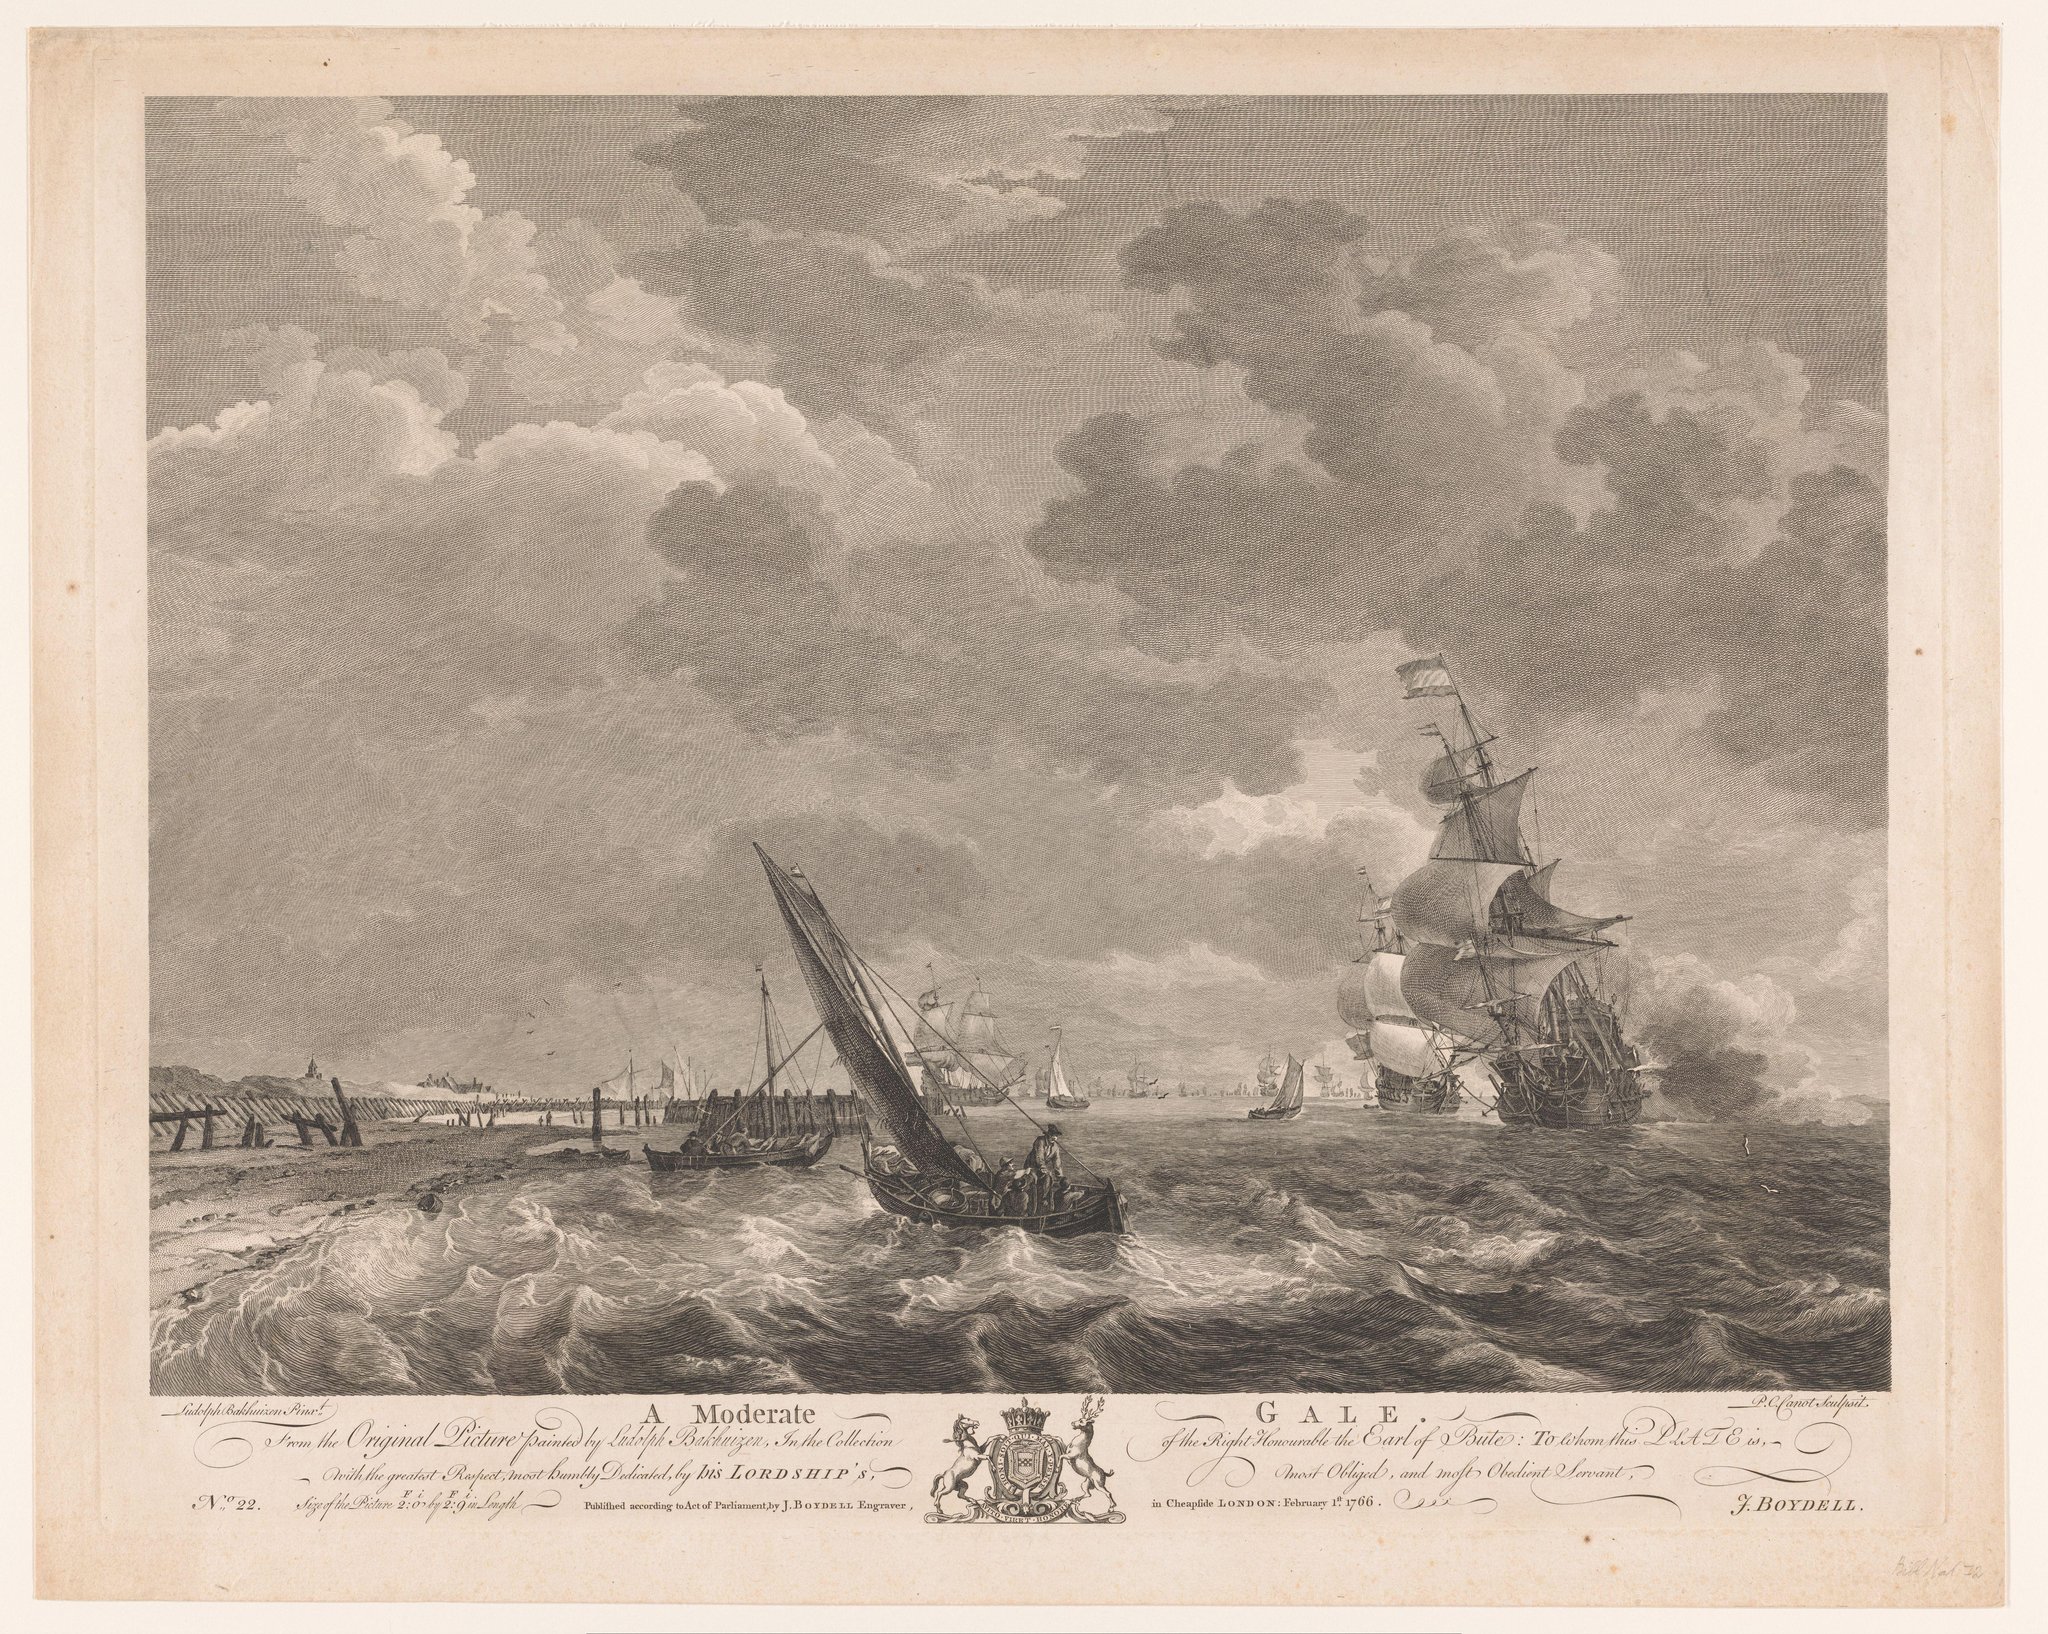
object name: print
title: A Moderate Gale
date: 1766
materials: paper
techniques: engraving, etching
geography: london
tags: ships (in general), winds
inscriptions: collector's mark: Lugt 2228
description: Prent hoort bij de serie 'The Most Capital Paintings in England', tussen 1763 en 1786 gepubliceerd door John Boydell.